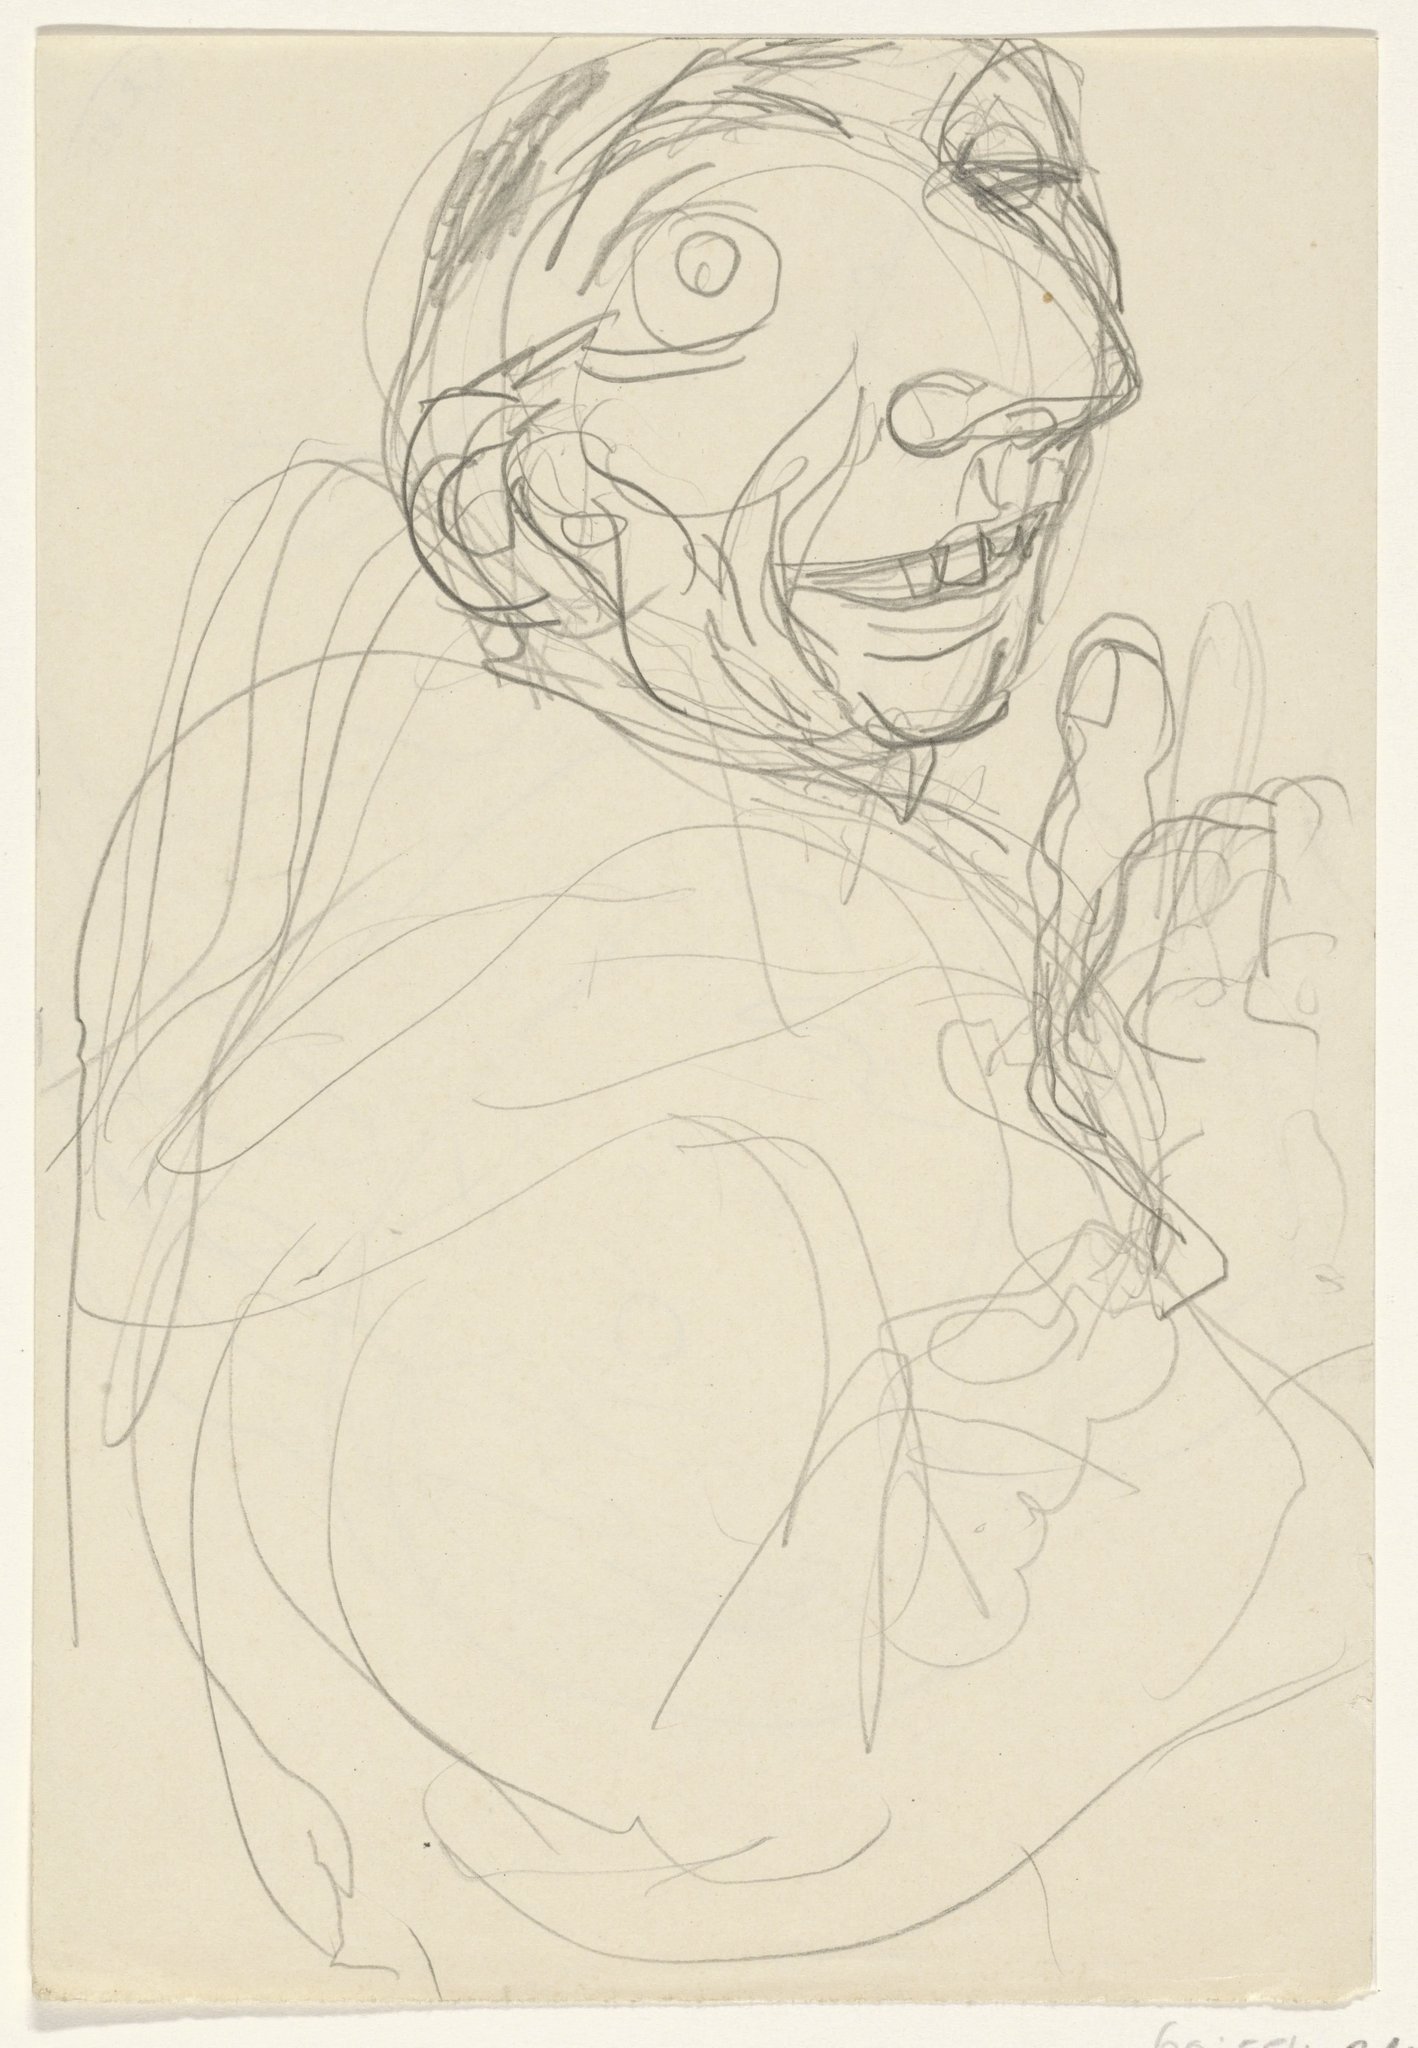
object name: drawing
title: Karikatuur van Leo Gestel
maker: leo gestel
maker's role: draughtsman, print maker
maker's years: 1881-1941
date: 1911-1941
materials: paper, pencil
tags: draughtsman, leo gestel, historical persons, portrait, self-portrait of artist